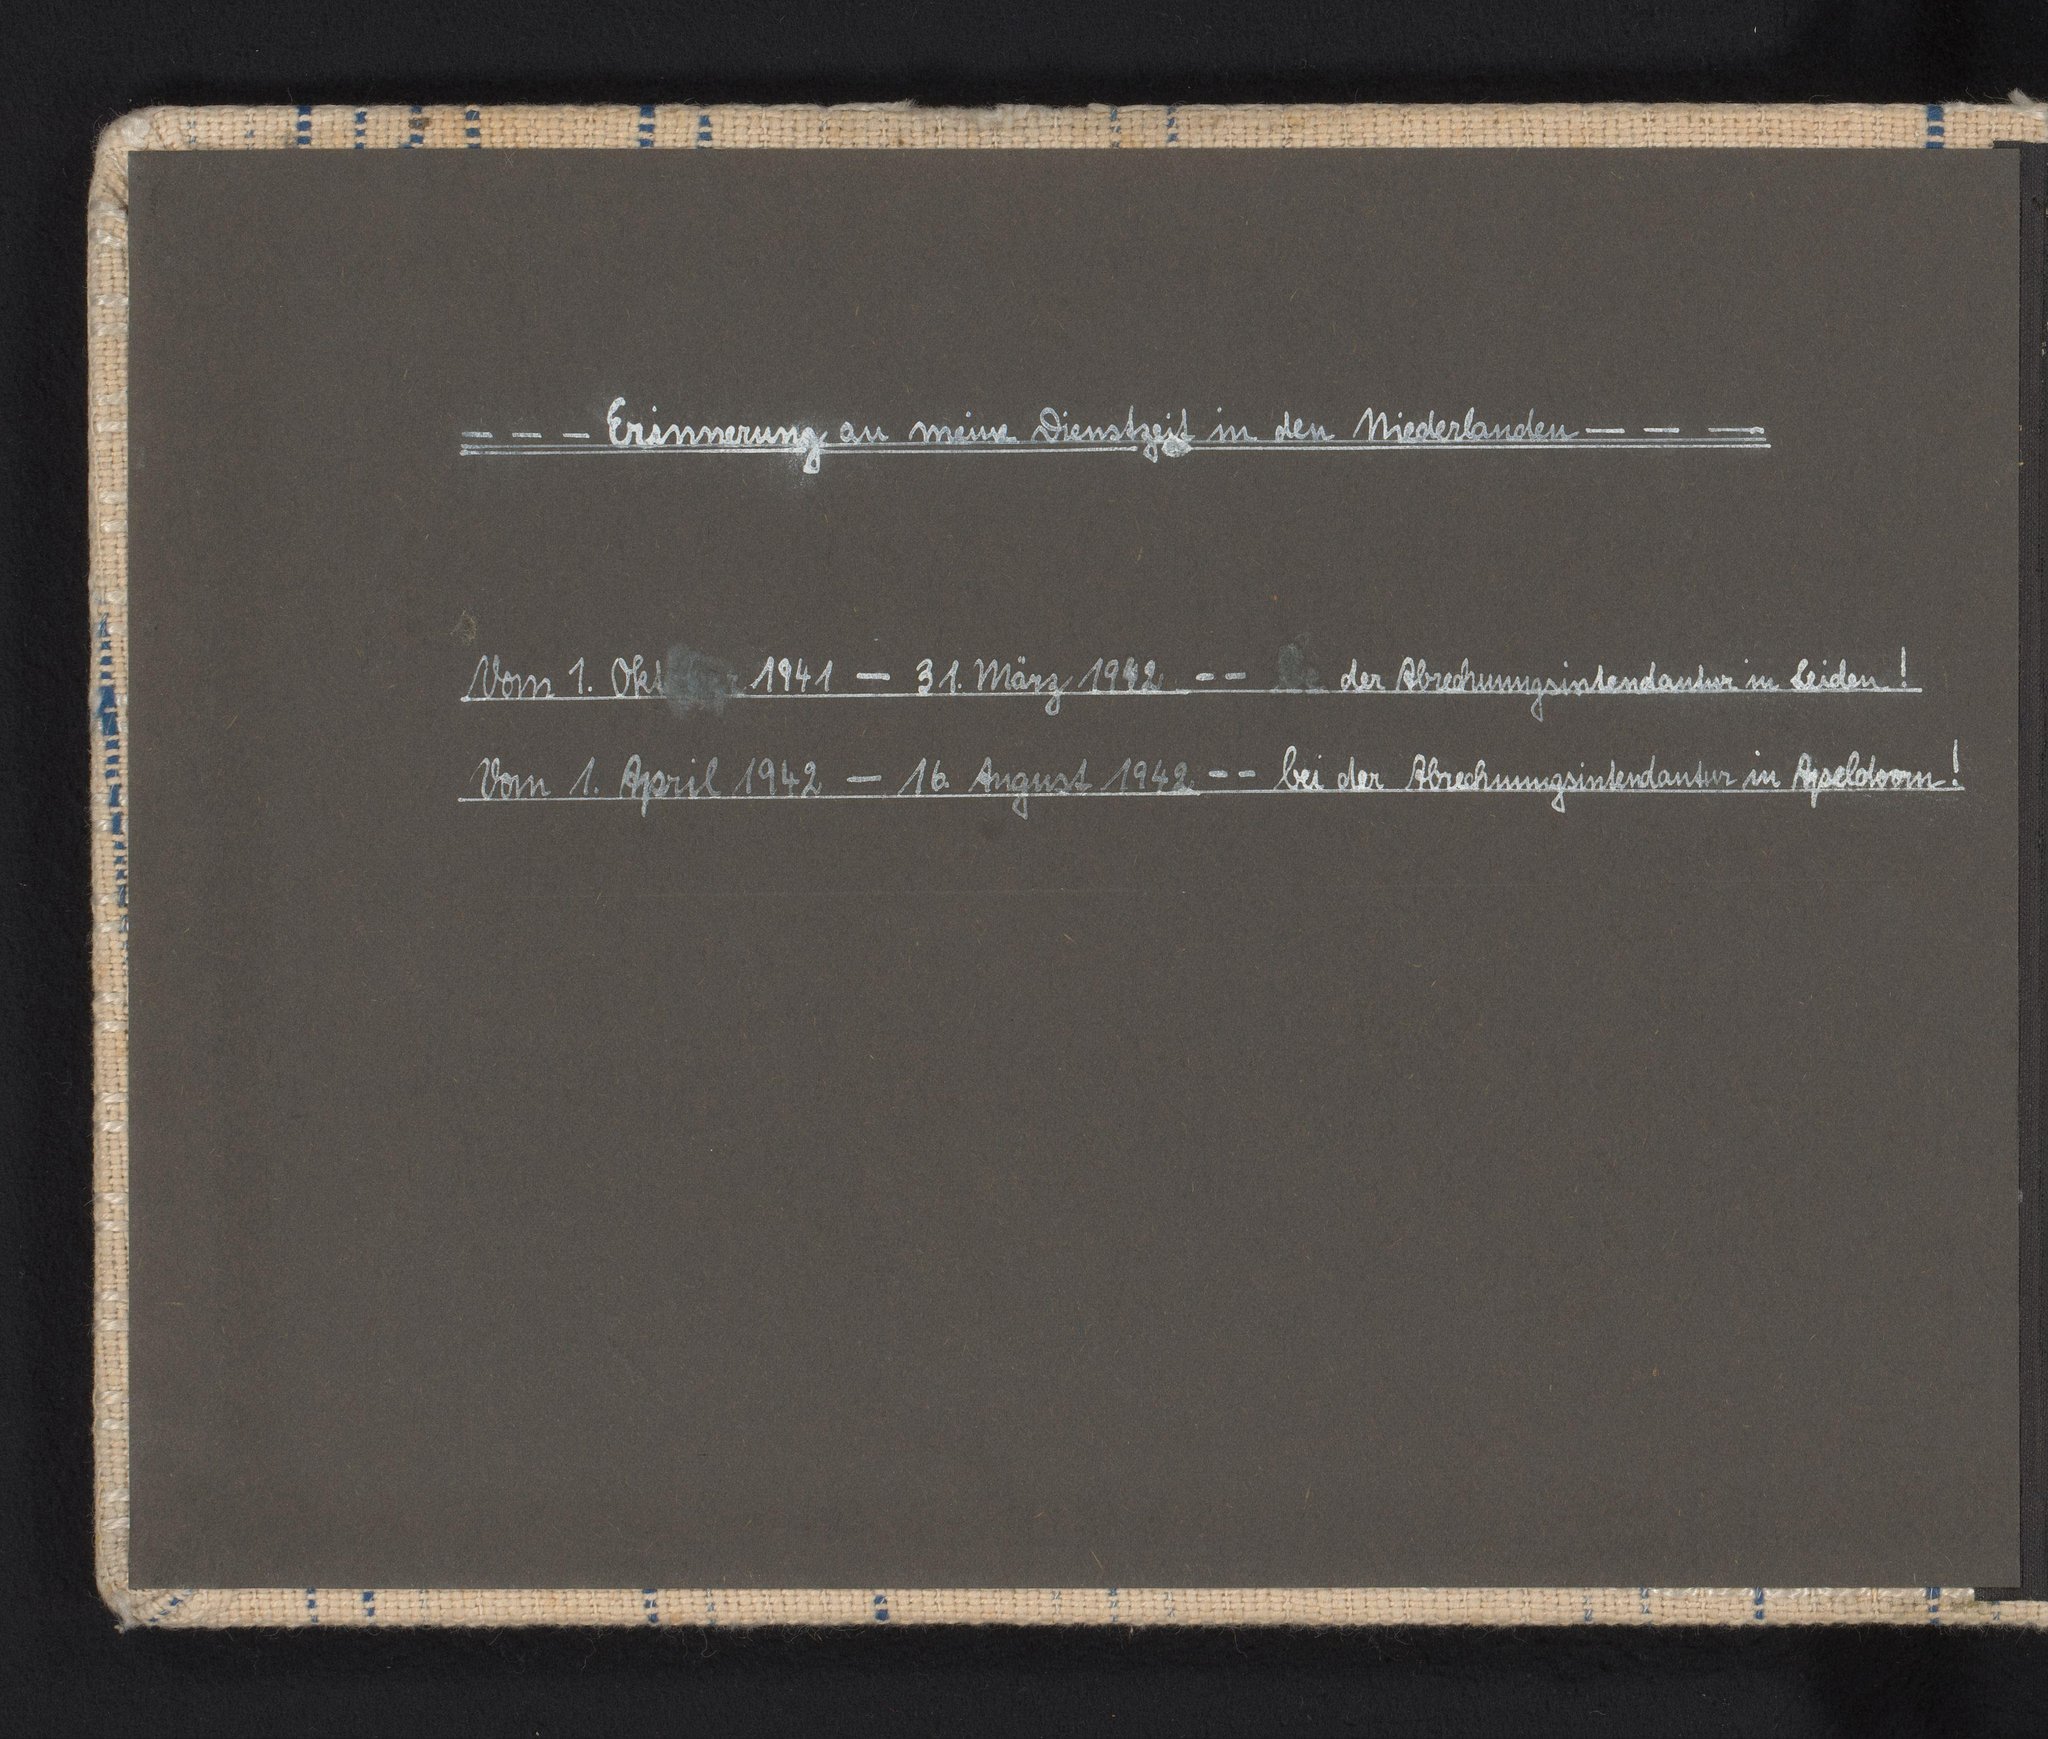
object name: album leaf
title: Handschrift over de diensttijd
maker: Anonymous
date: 1941-1942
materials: cardboard, ink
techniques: pen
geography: germany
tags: wehrmacht, tweede wereldoorlog, bezetting van nederland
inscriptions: annotation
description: Handschrift over de diensttijd, op het schutblad voorin het album. Onderdeel van het fotoalbum Abrechnungsintendantur van de Wehrmacht 1941-1943.